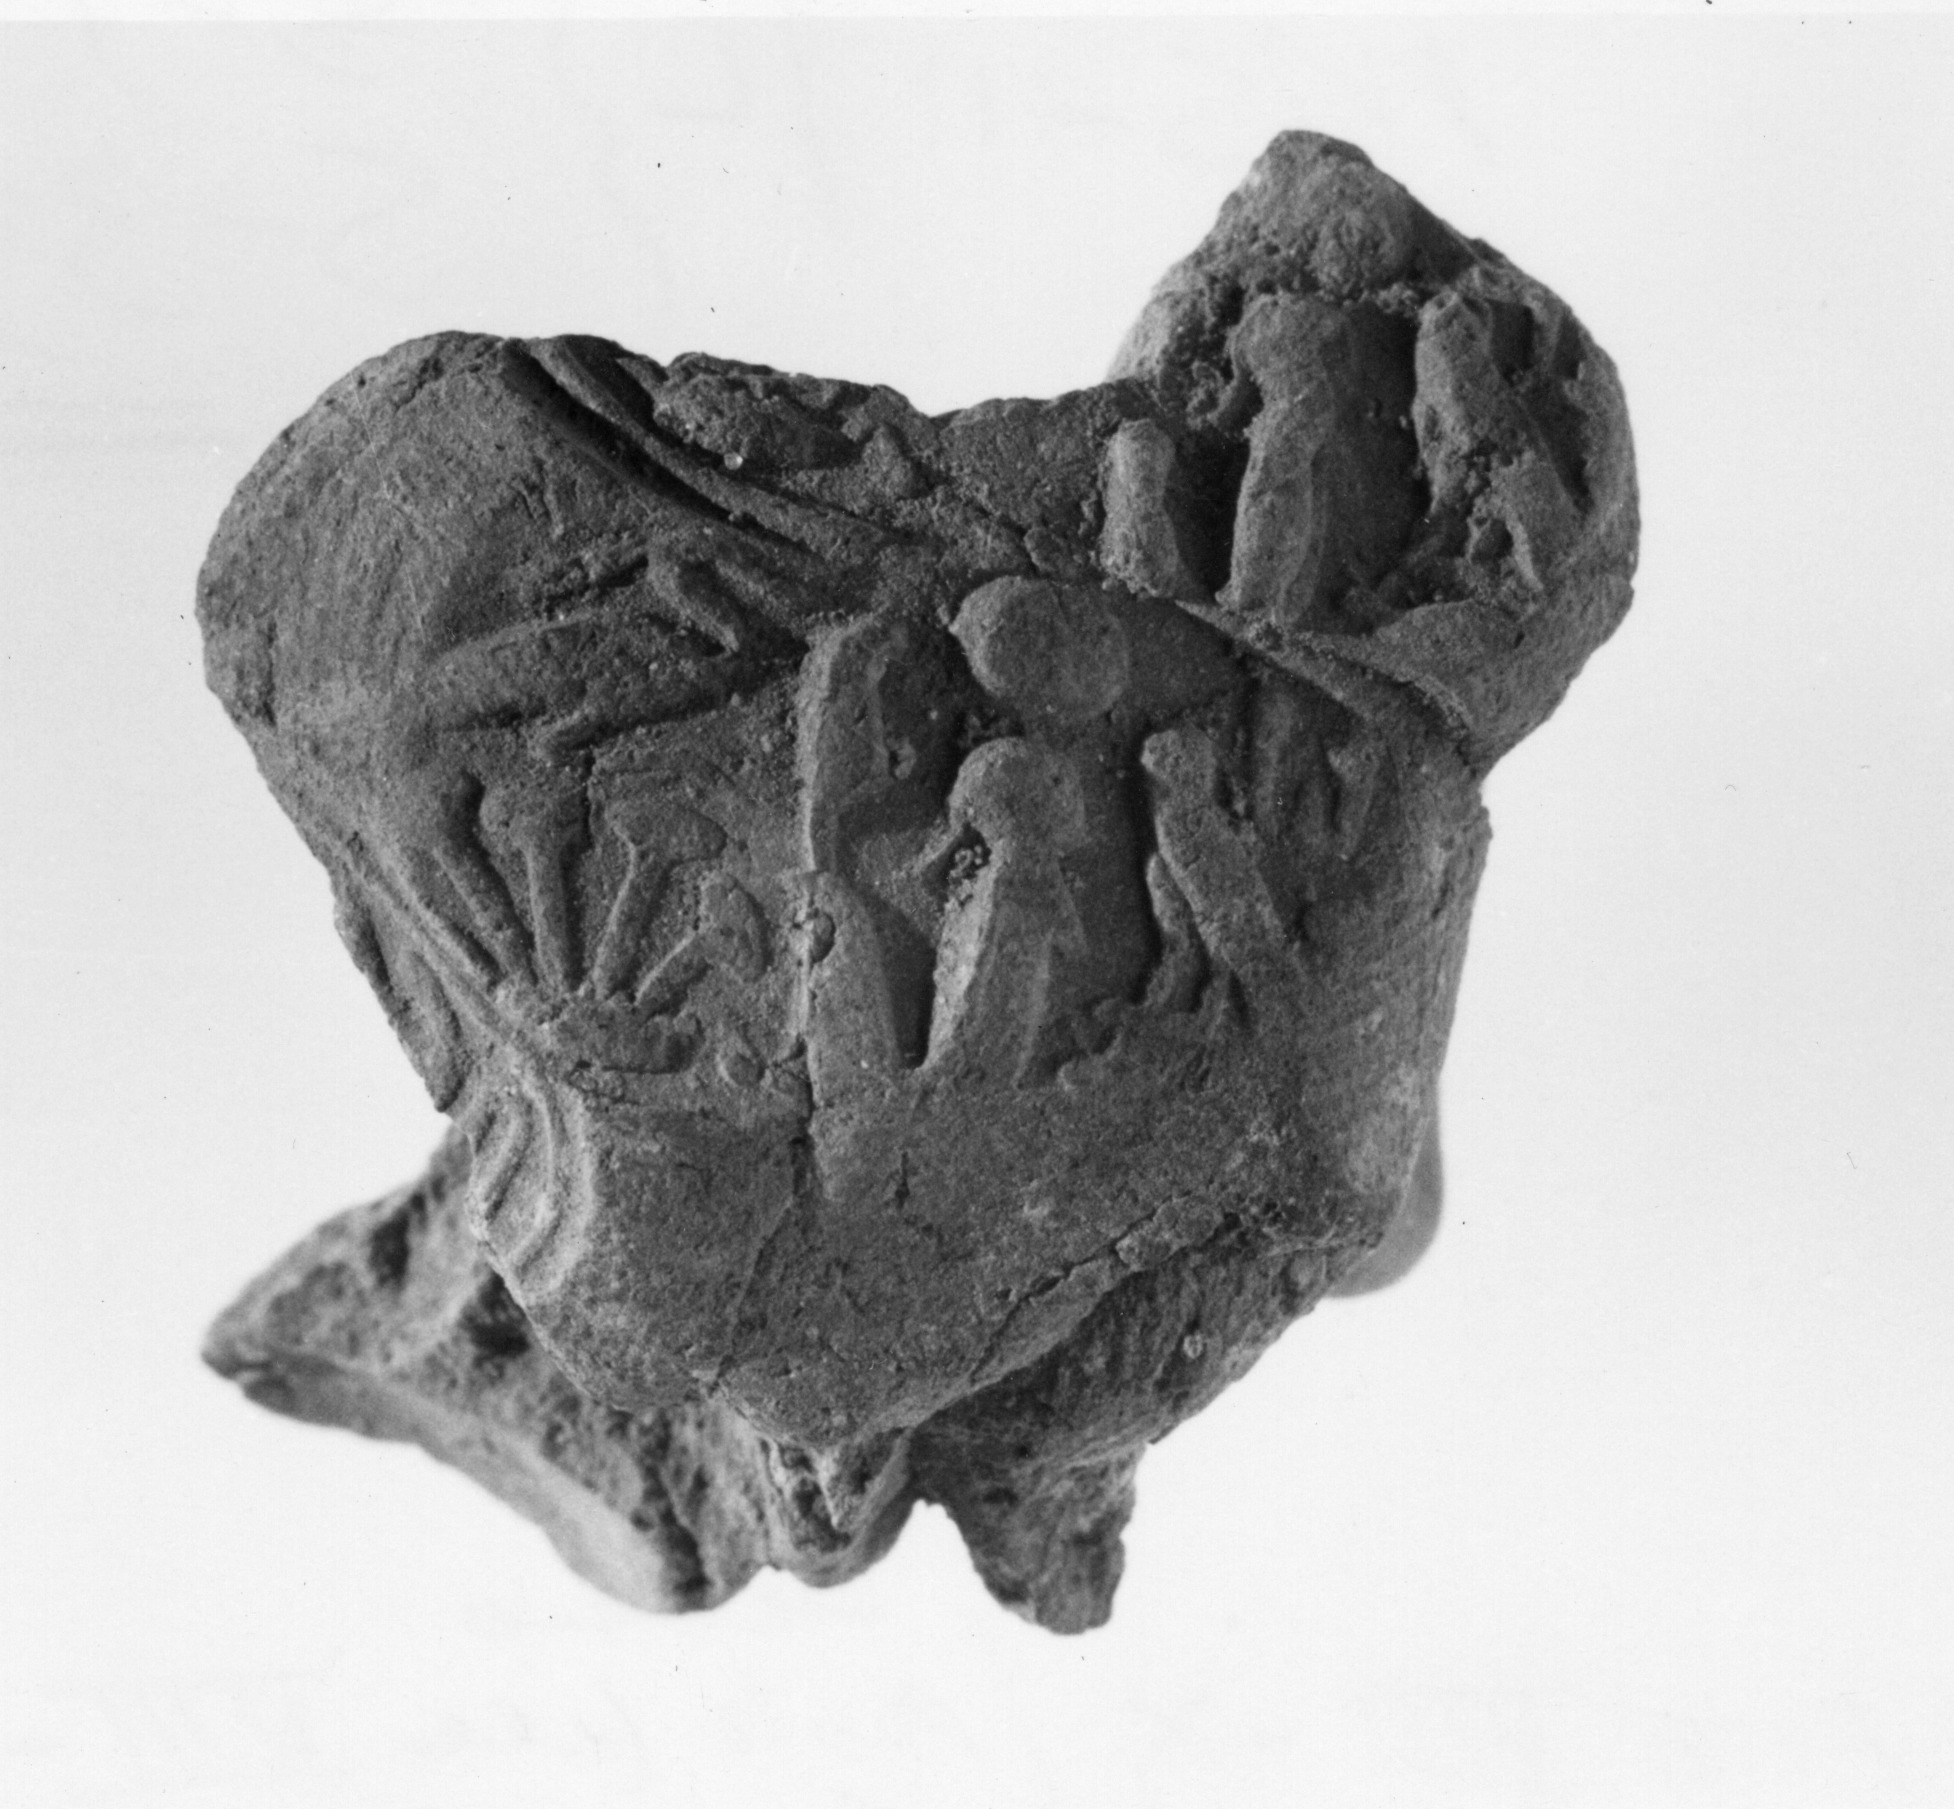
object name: sealing, amenhotep iii, nebmaatre, cobra,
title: Document Sealing With Multiple Seal Impressions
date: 1390-1352 BCE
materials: mud